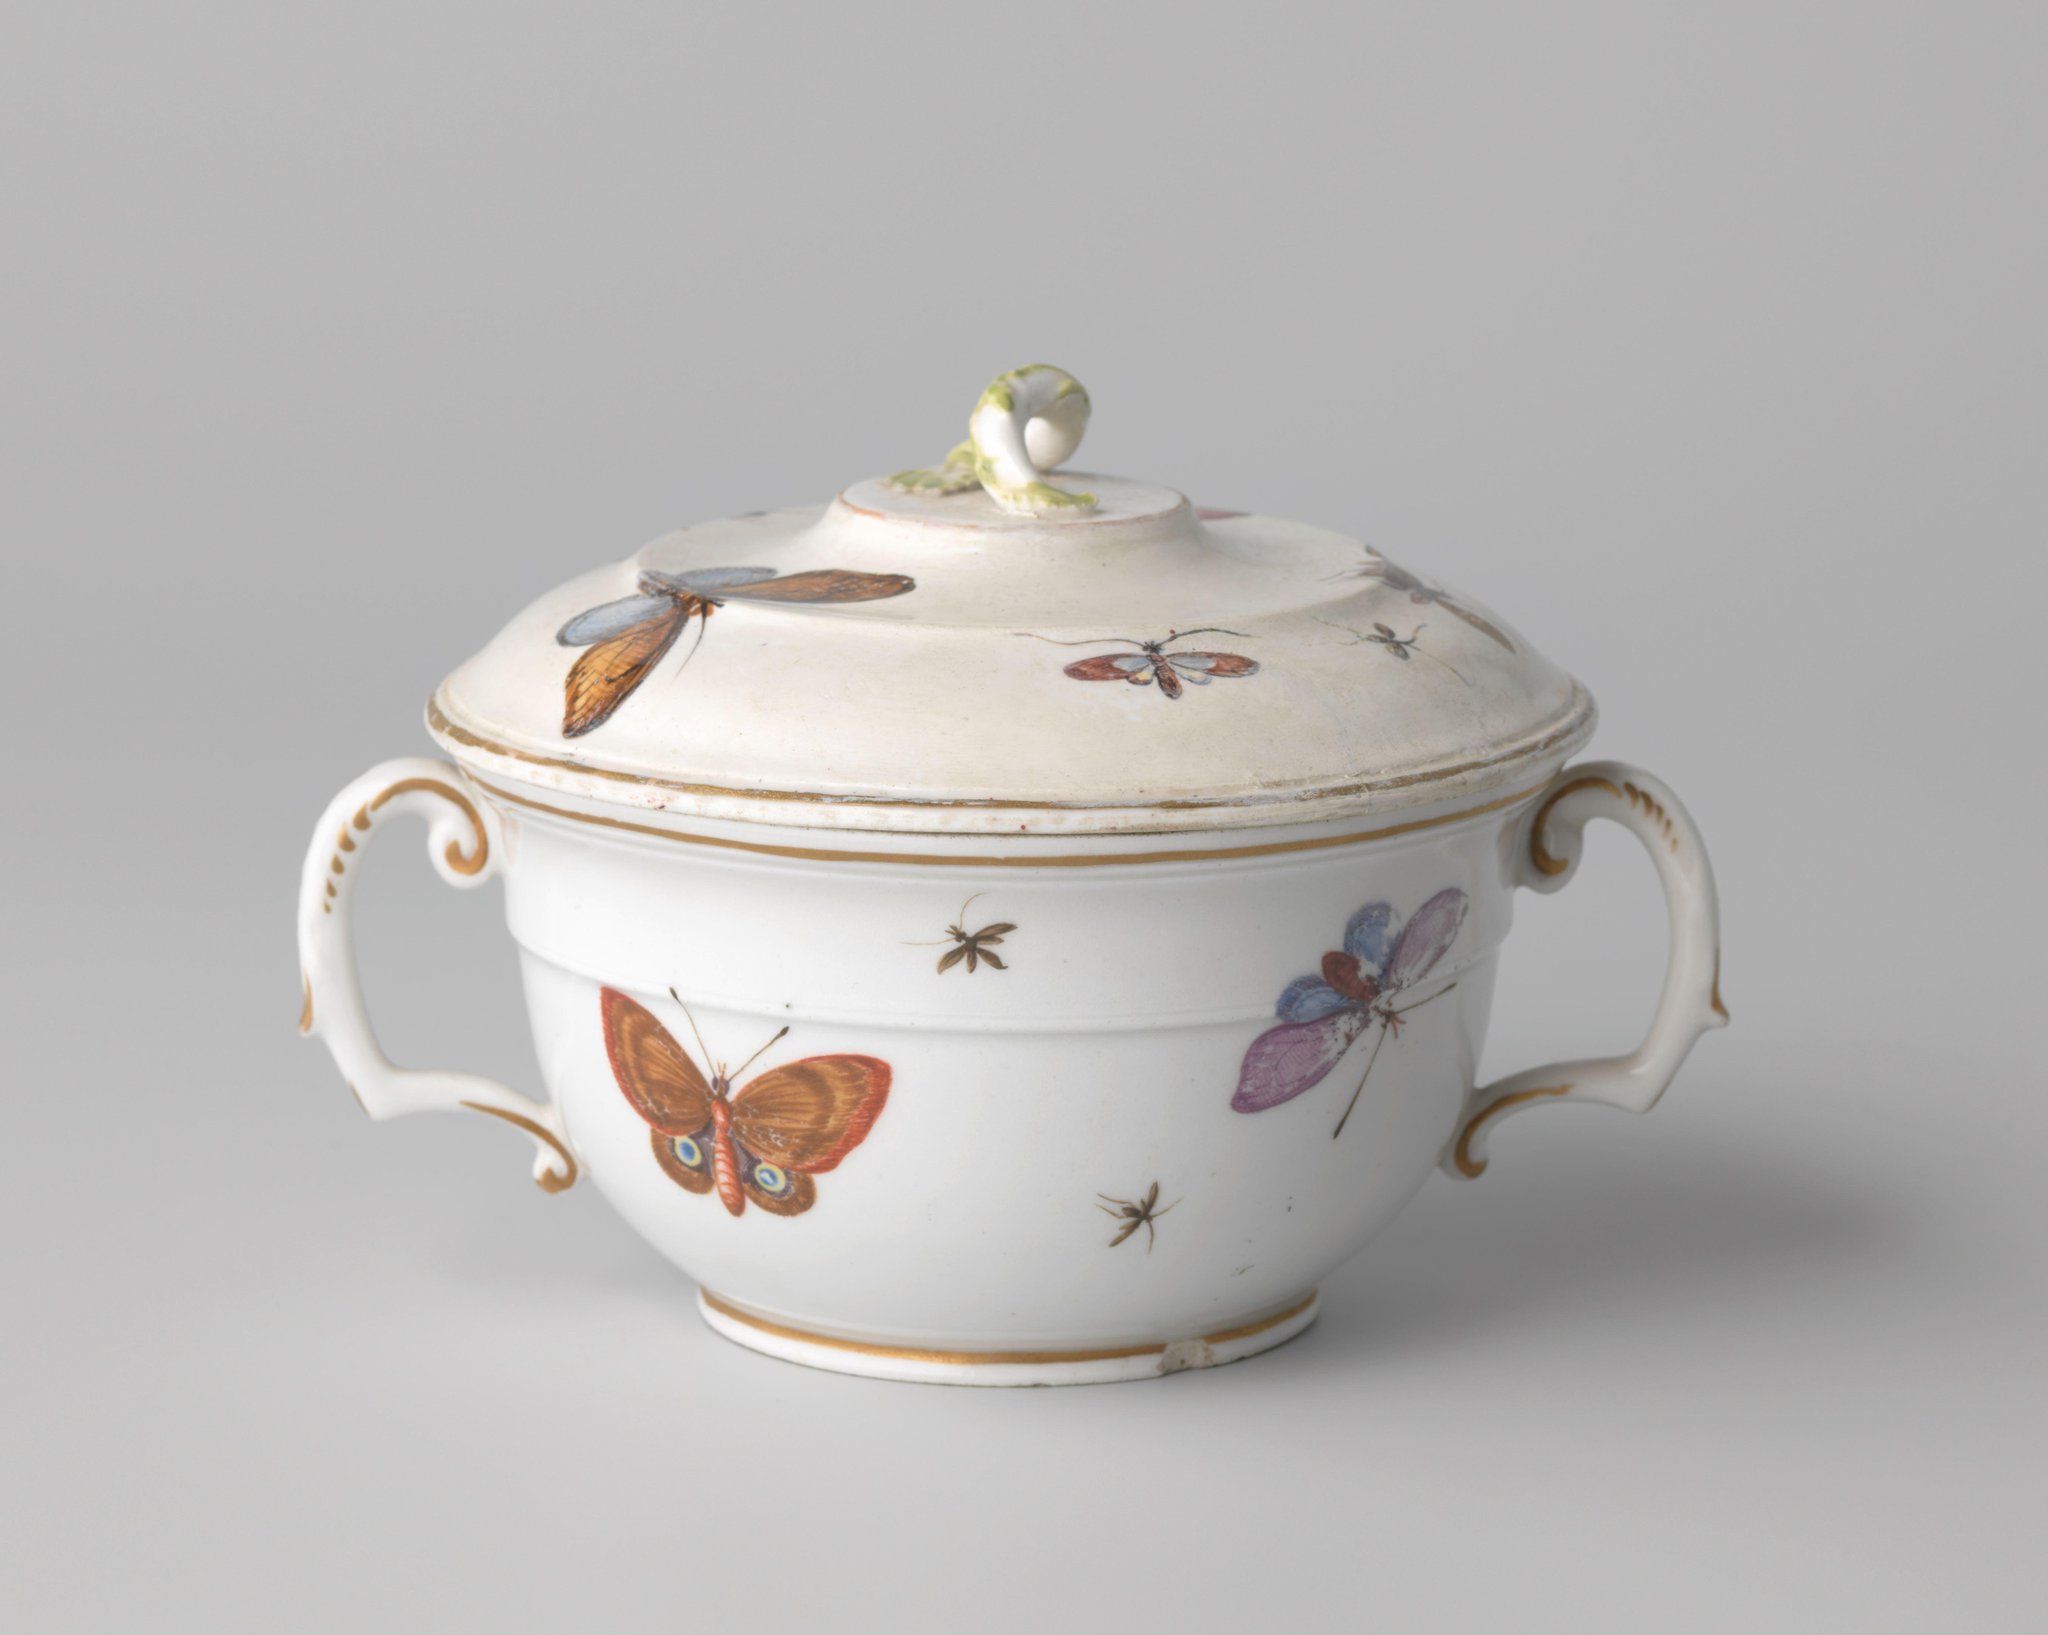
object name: tureen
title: Terrine, beschilderd met vlinders en insecten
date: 1778-1782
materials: porcelain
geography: loosdrecht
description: Soup tureen and stand. Porcelain. Loosdrecht, c. 1778 - 1782. Factory of Joannes de Mol.